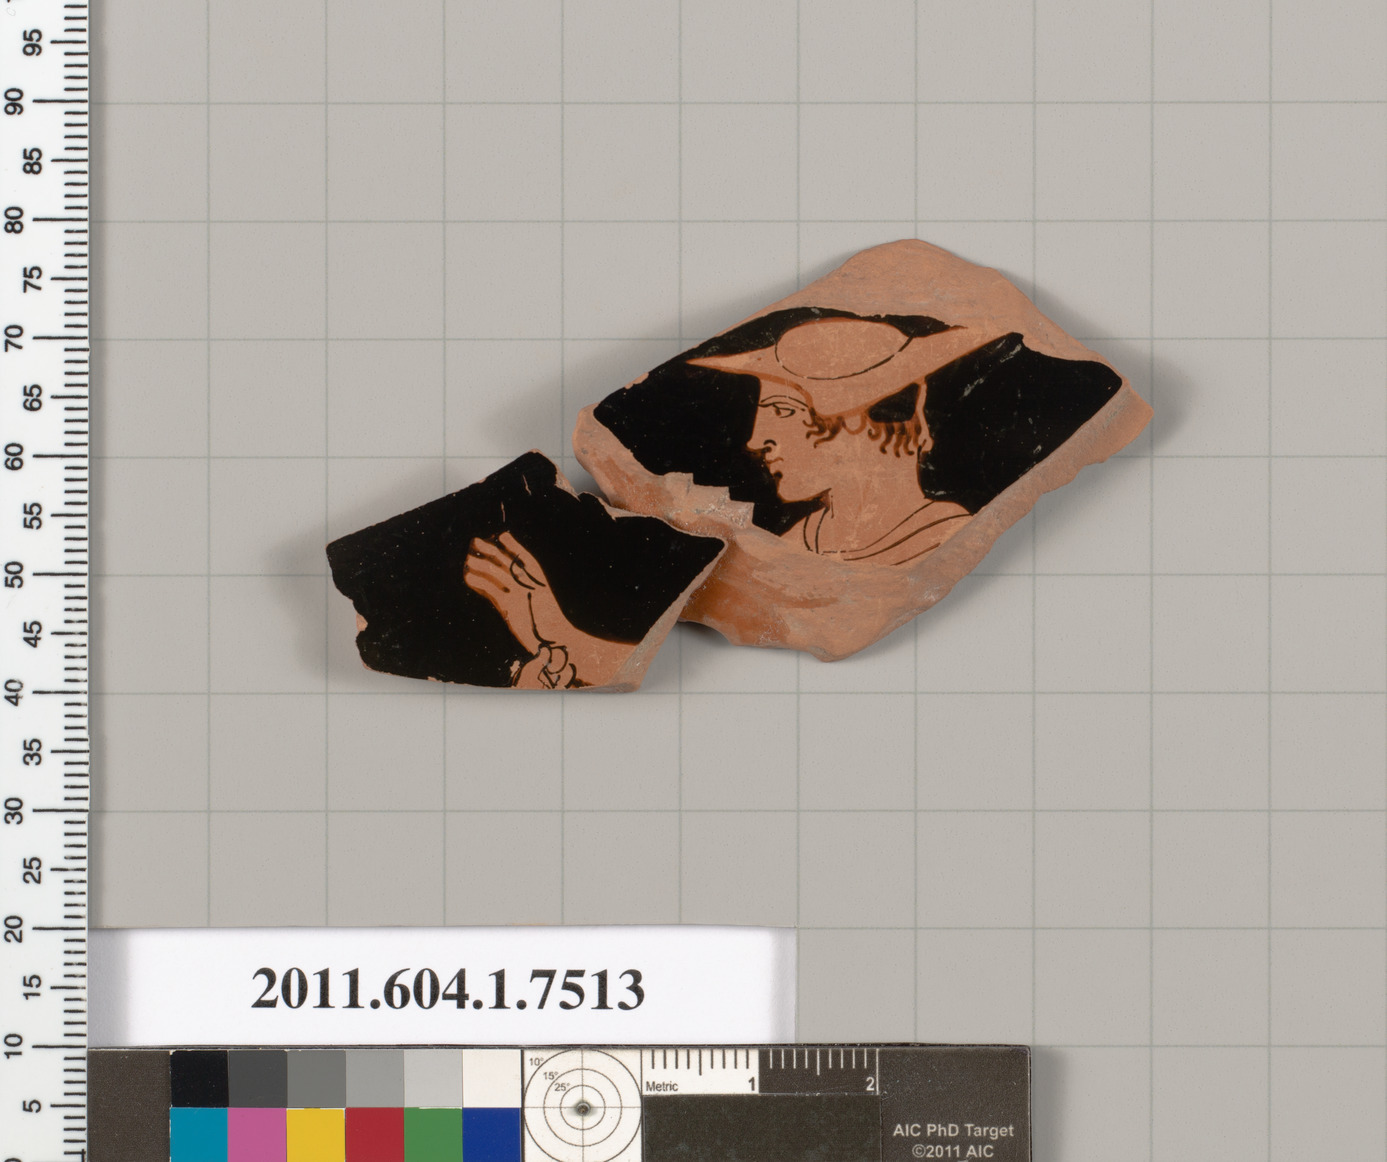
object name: kylix fragment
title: Terracotta fragment of a kylix (drinking cup)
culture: greek, attic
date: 460-450 BCE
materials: terracotta